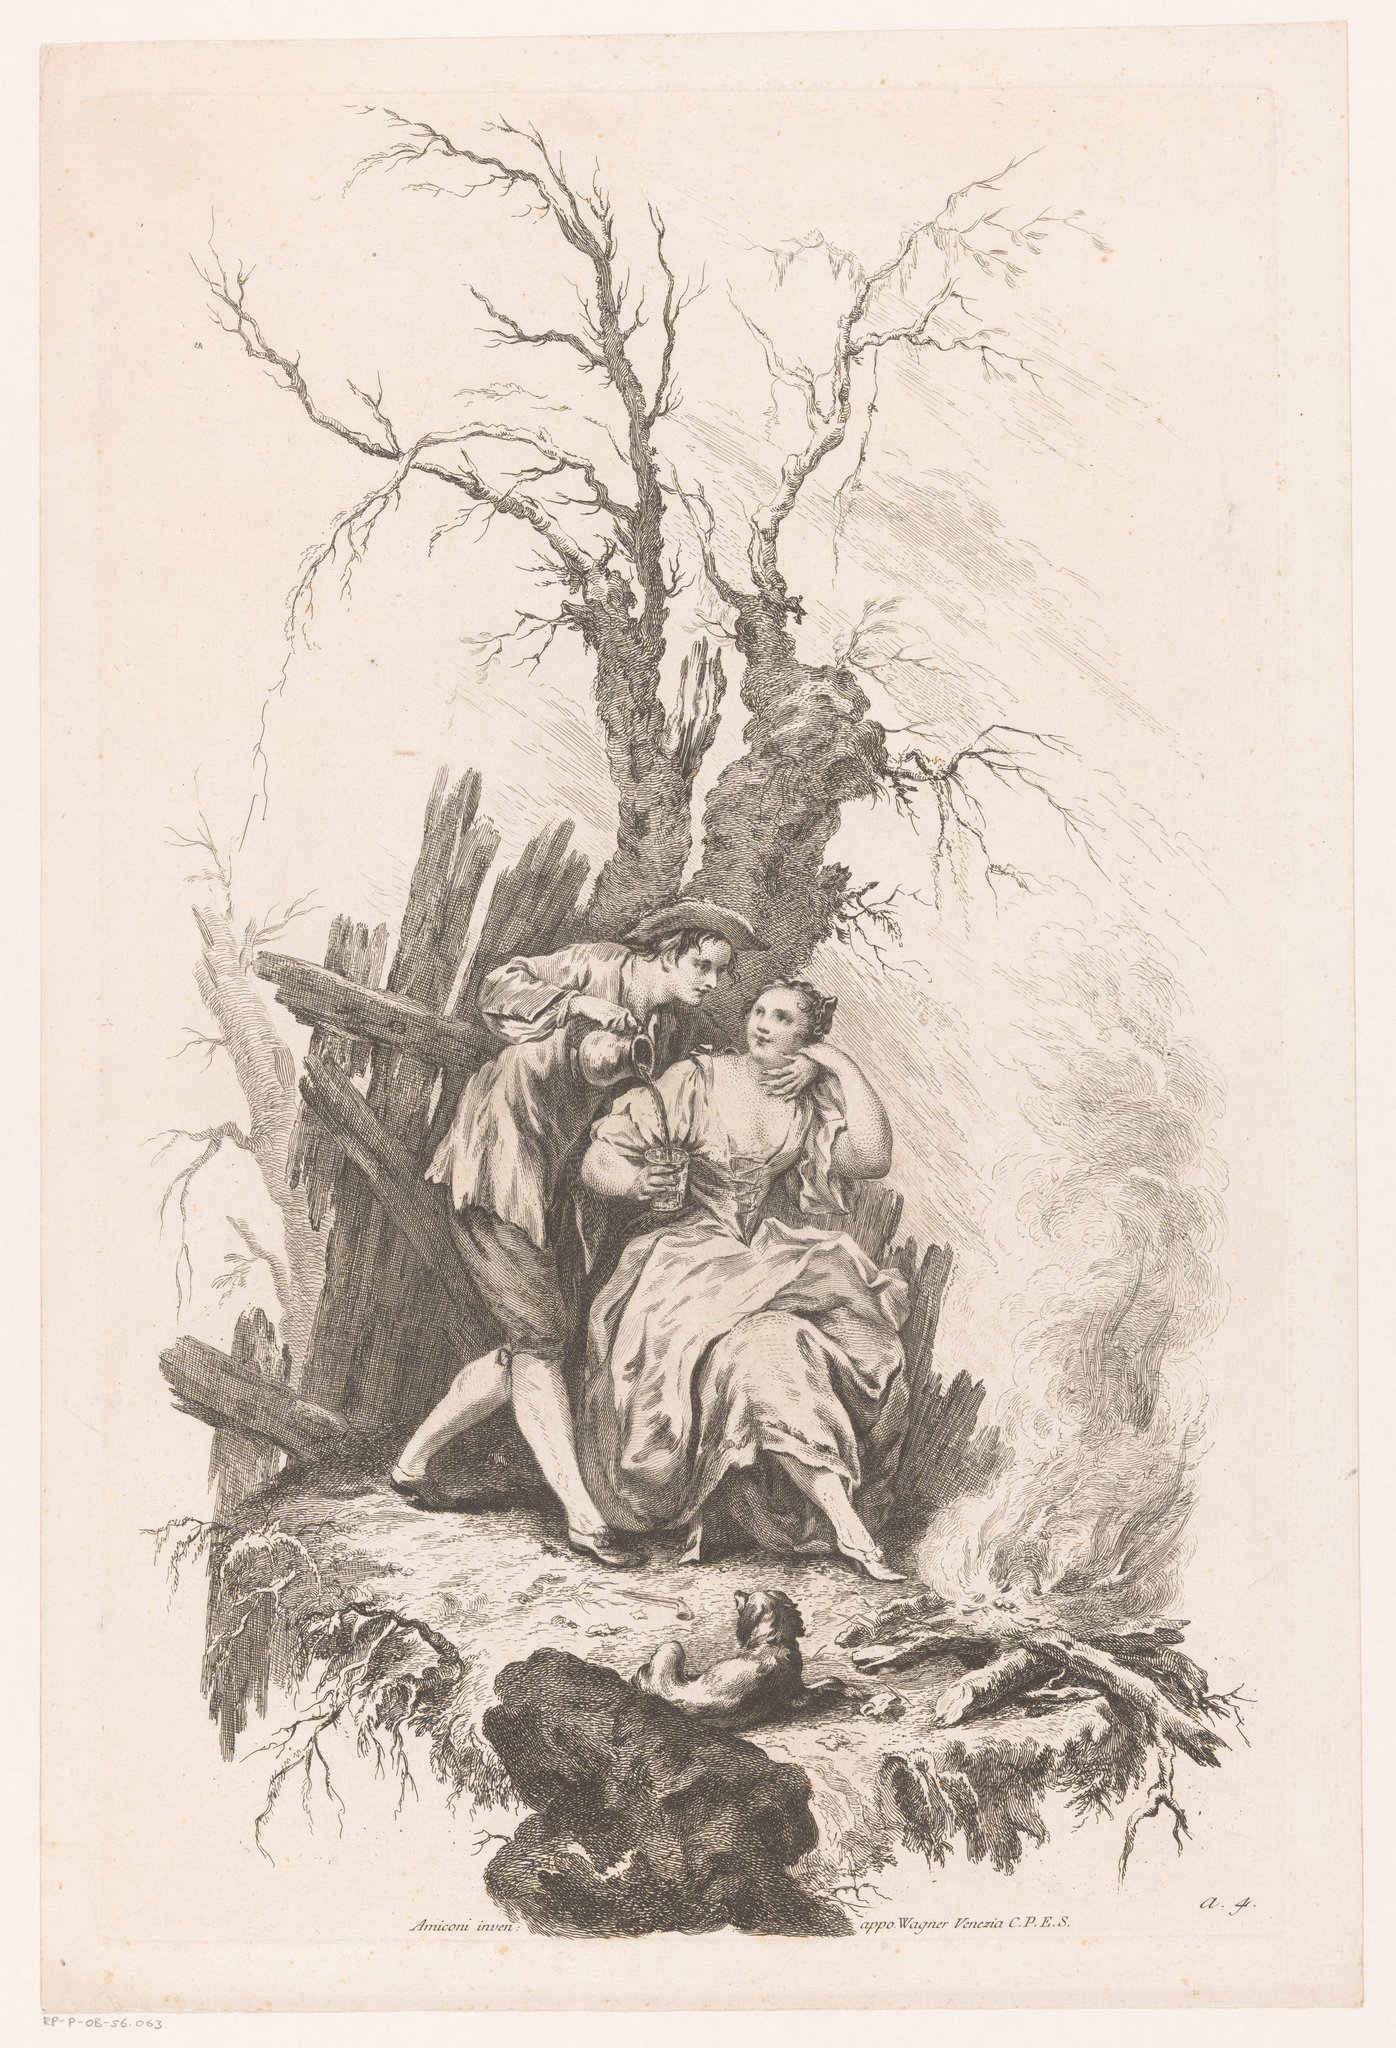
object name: print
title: Vier jaargetijden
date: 1739-1780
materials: paper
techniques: engraving, etching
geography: venice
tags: pouring, pipe ~ tobacco, winter ~ human activities (the four seasons of the year), dog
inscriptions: collector's mark: Lugt 2228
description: Prent maakt deel uit van een serie bestaande uit vier genummerde prenten van de jaargetijden.